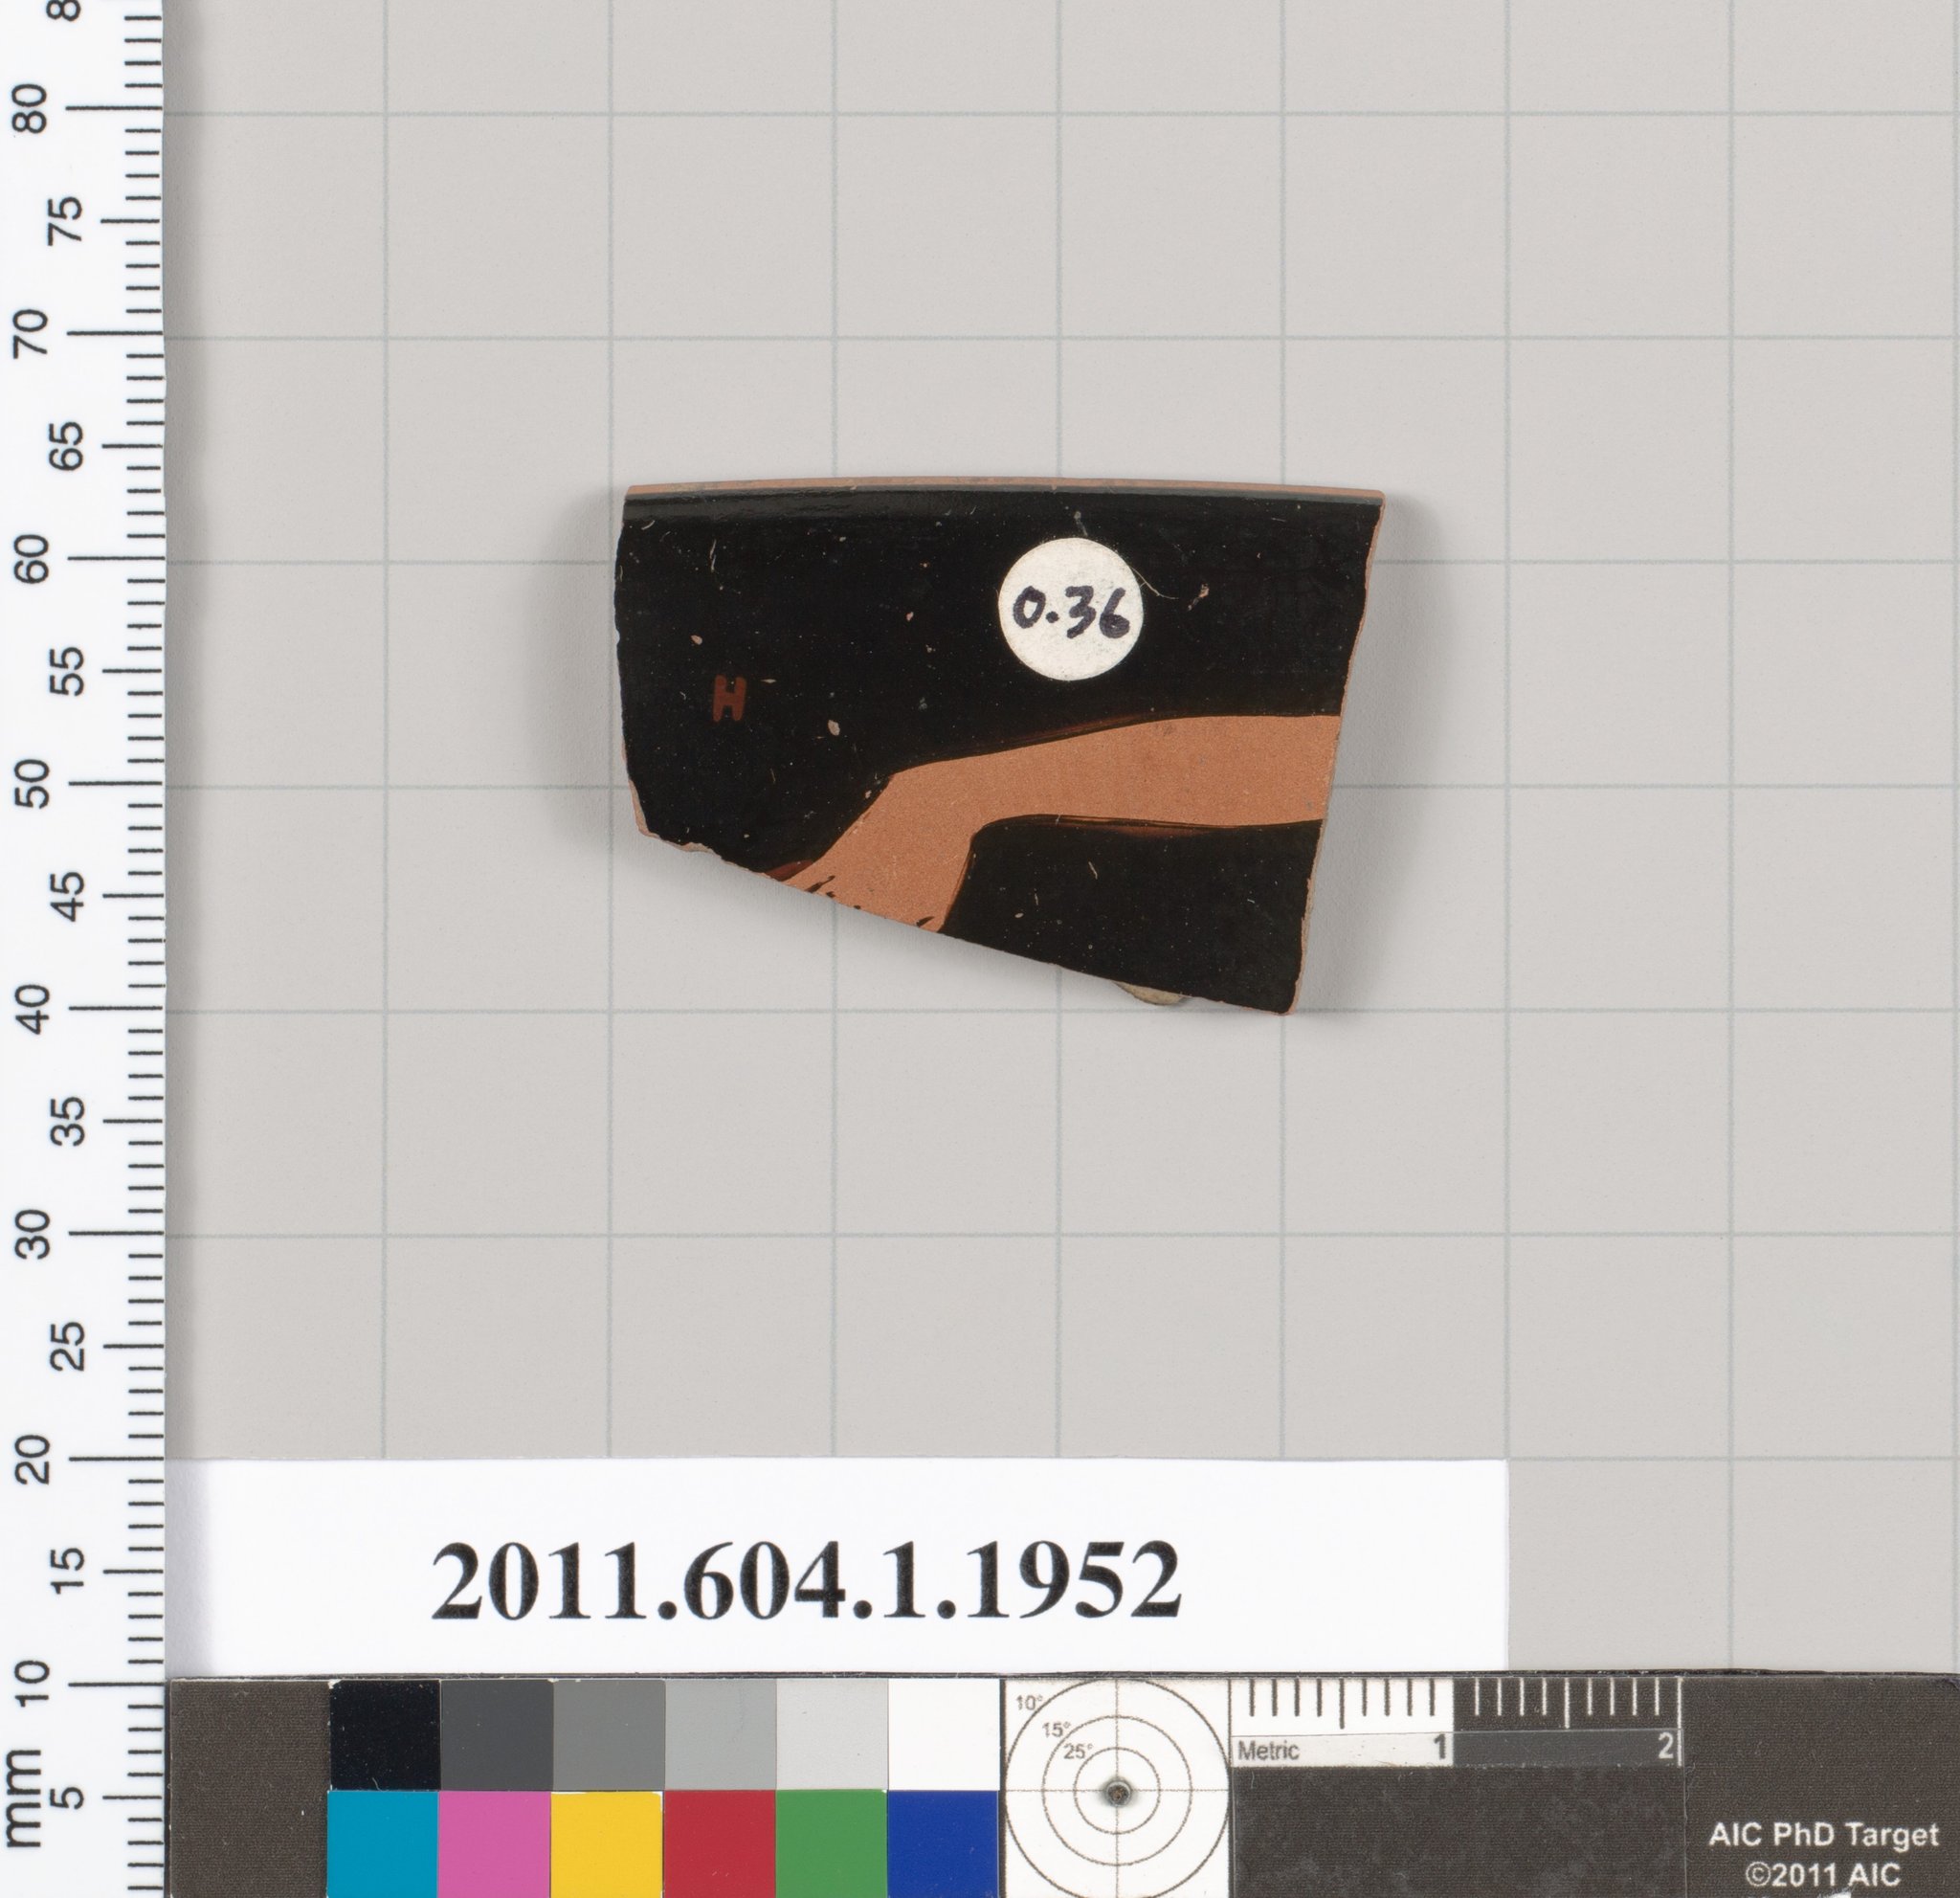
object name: kylix fragment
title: Terracotta rim fragment of a kylix (drinking cup)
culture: greek, attic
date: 490-480 BCE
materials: terracotta